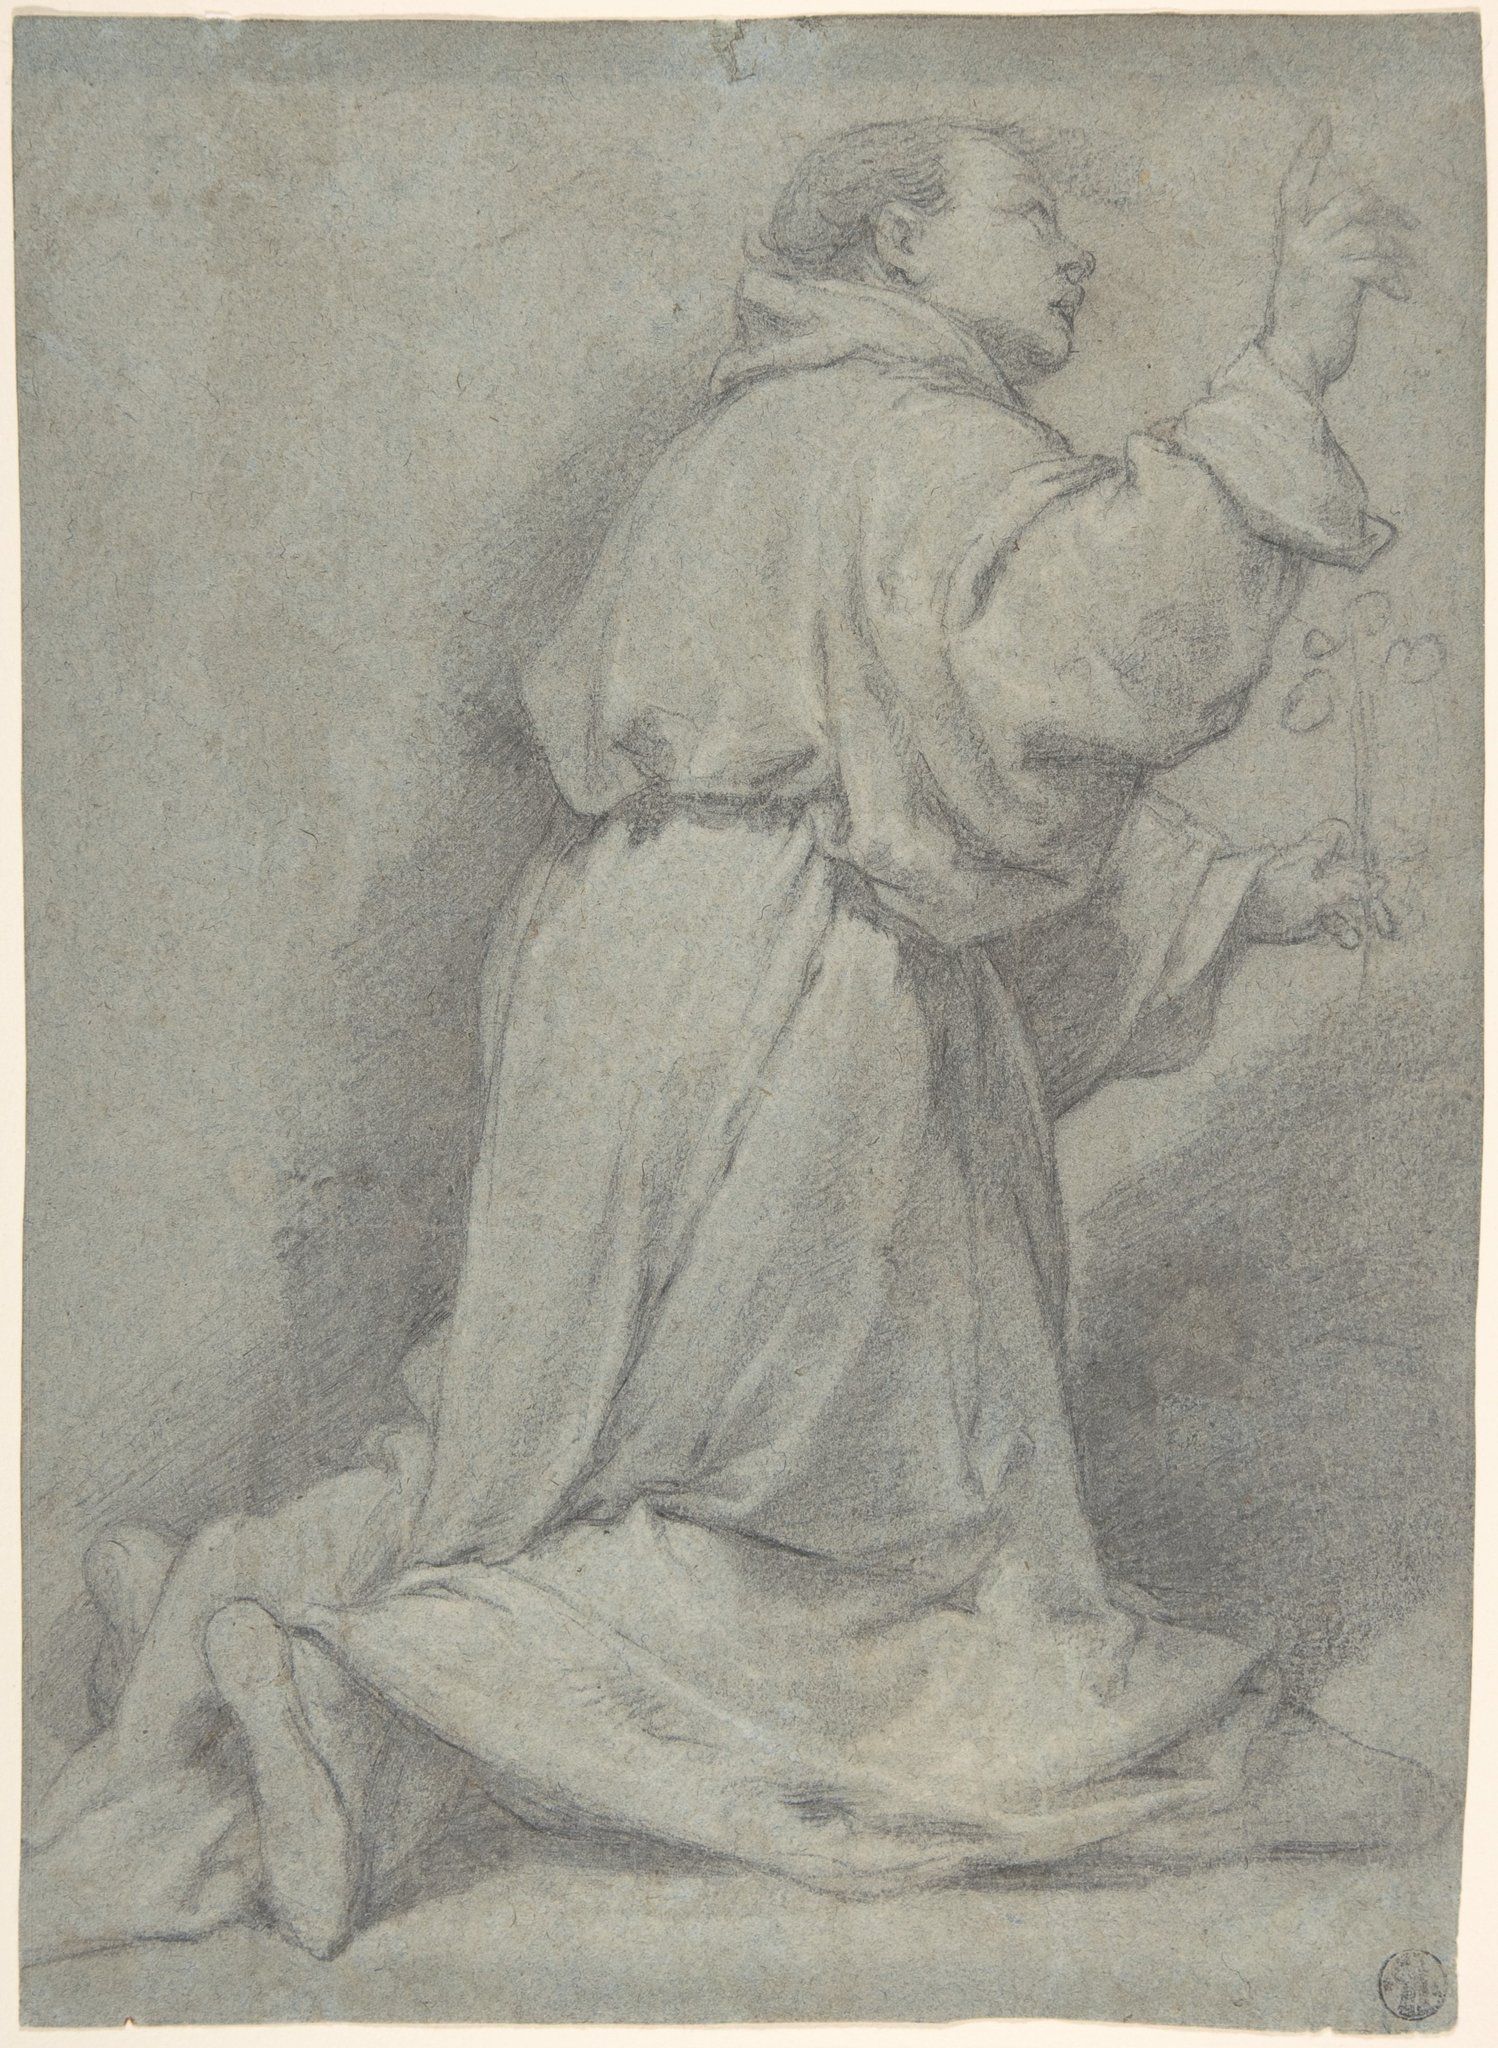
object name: drawing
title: Kneeling Monk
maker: denijs calvaert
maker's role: artist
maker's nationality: netherlandish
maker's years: 1540-1619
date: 1534-1633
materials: chalk, paper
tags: monks